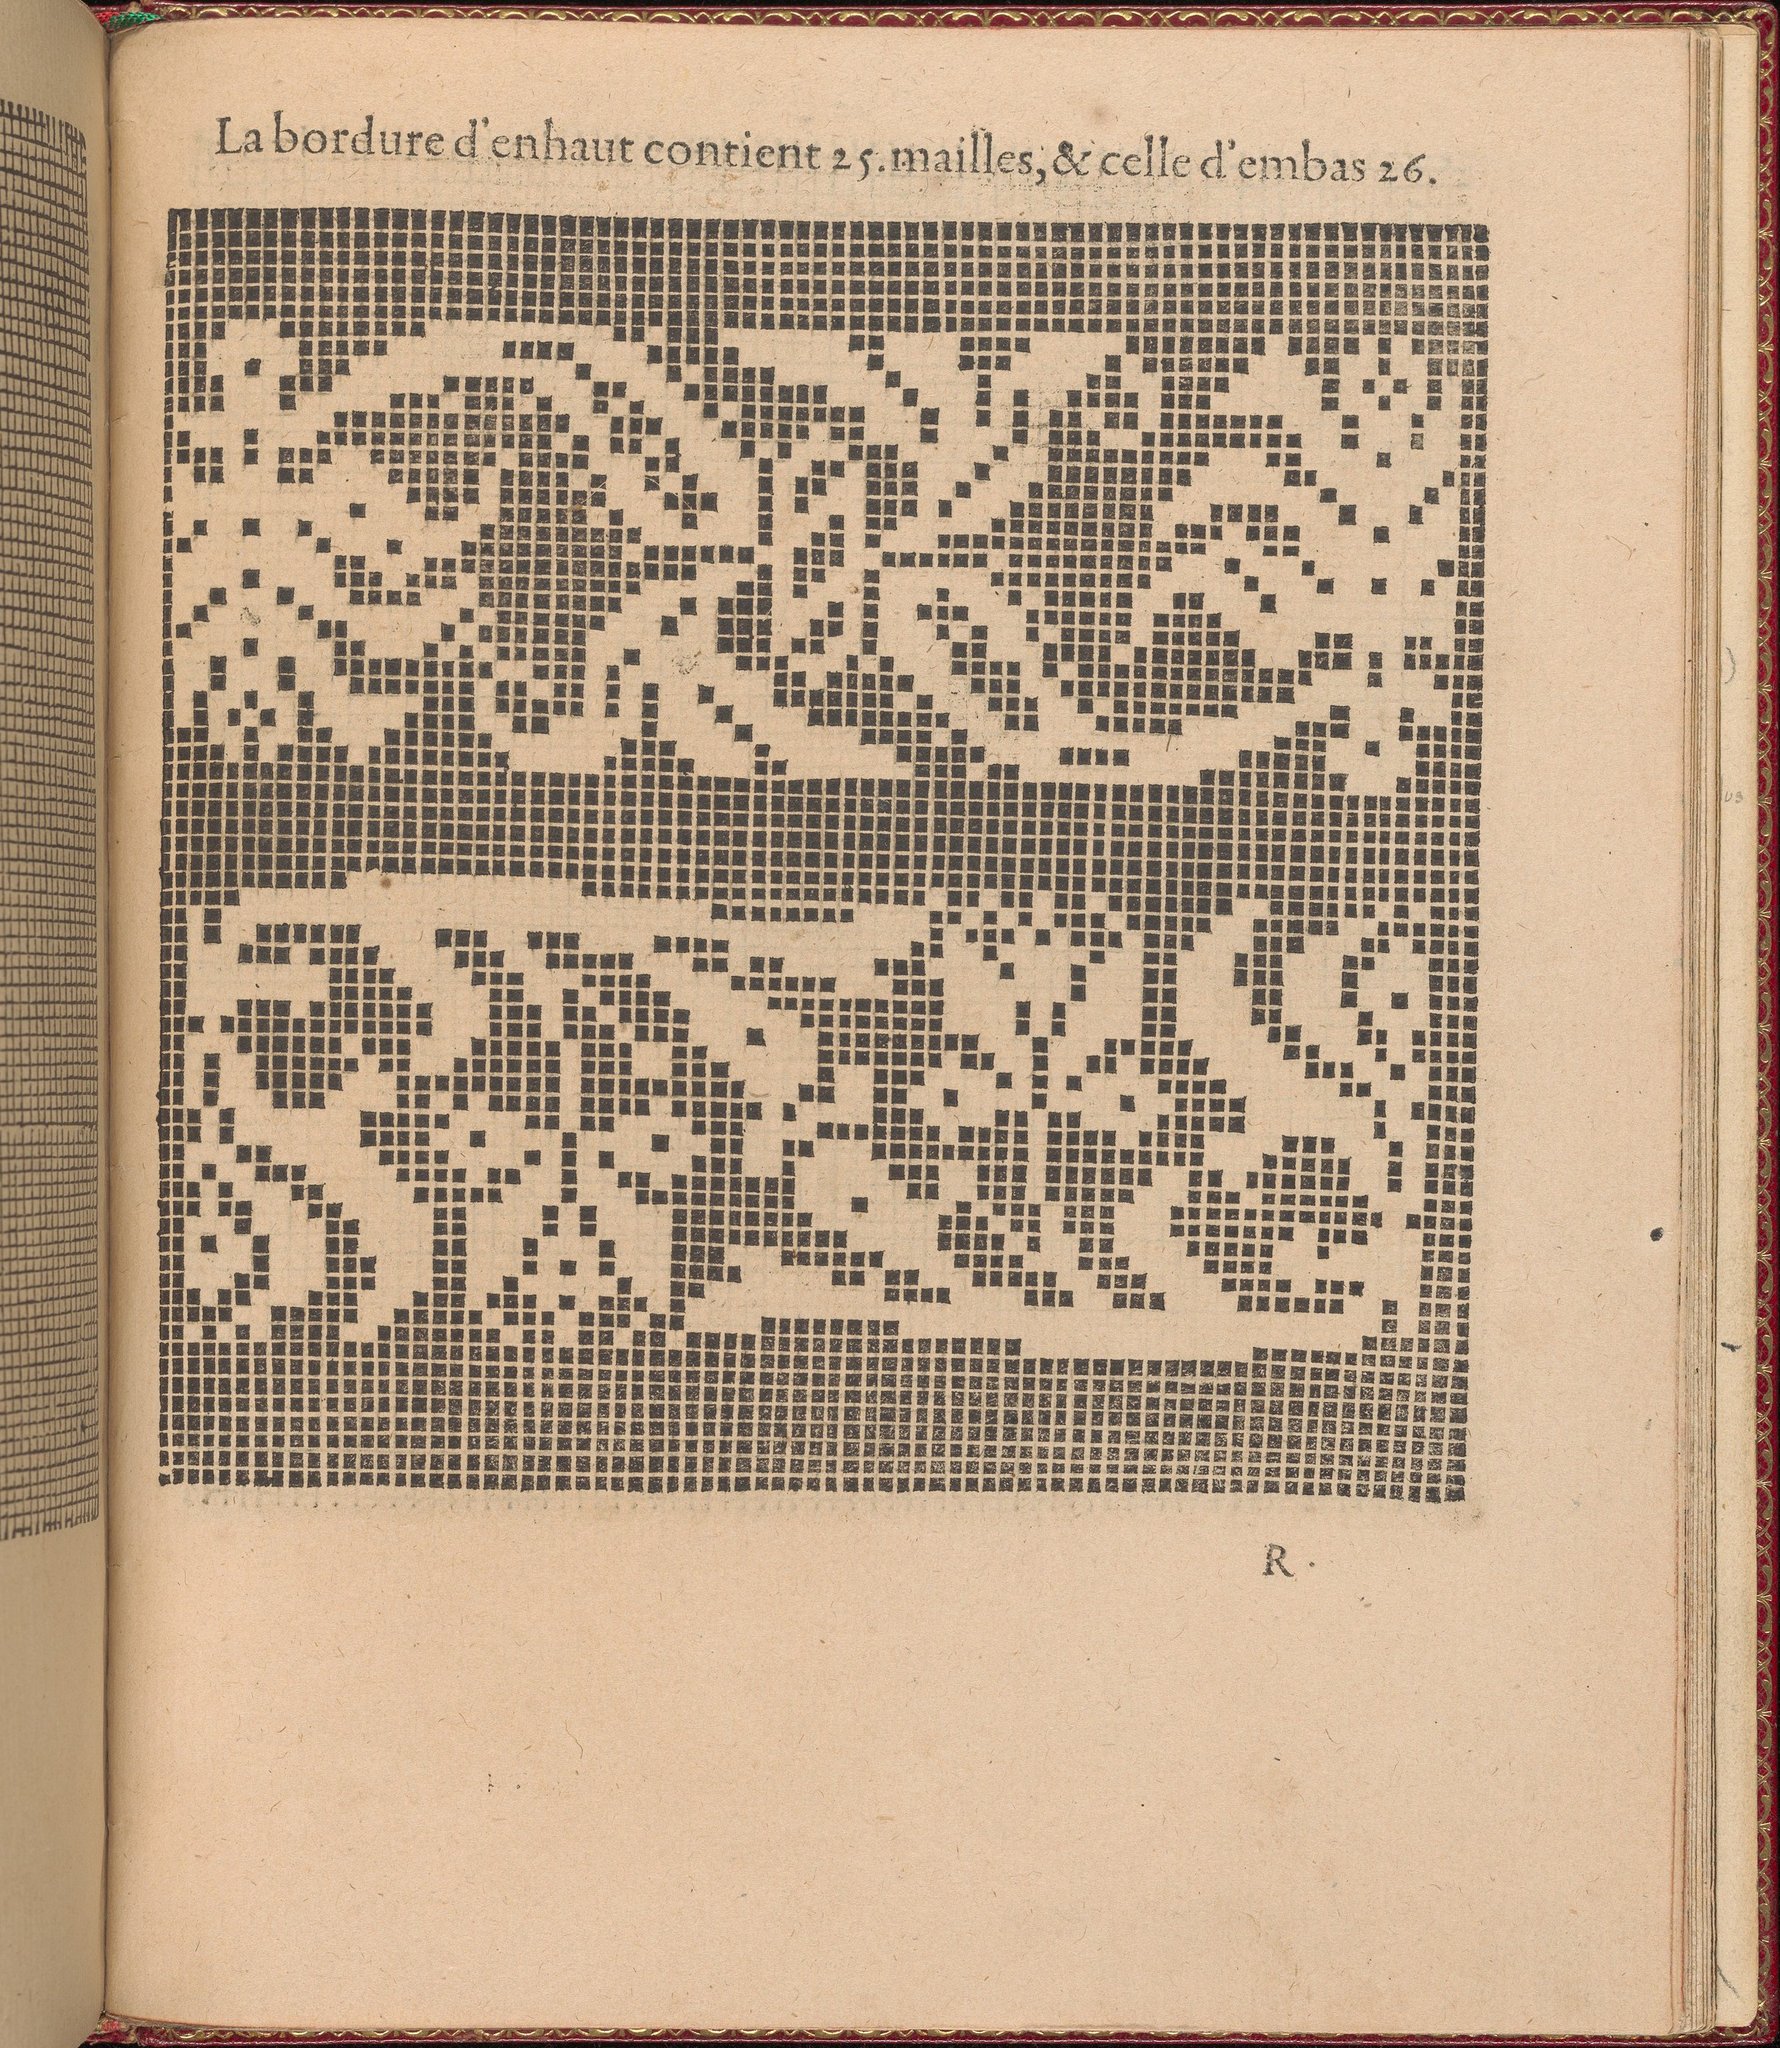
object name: book print ornament architecture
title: Les Singuliers et Nouveaux Portraicts... page 65 (recto)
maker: federico de vinciolo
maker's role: designer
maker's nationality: italian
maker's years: 1582-1599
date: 1588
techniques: woodcut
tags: ornament